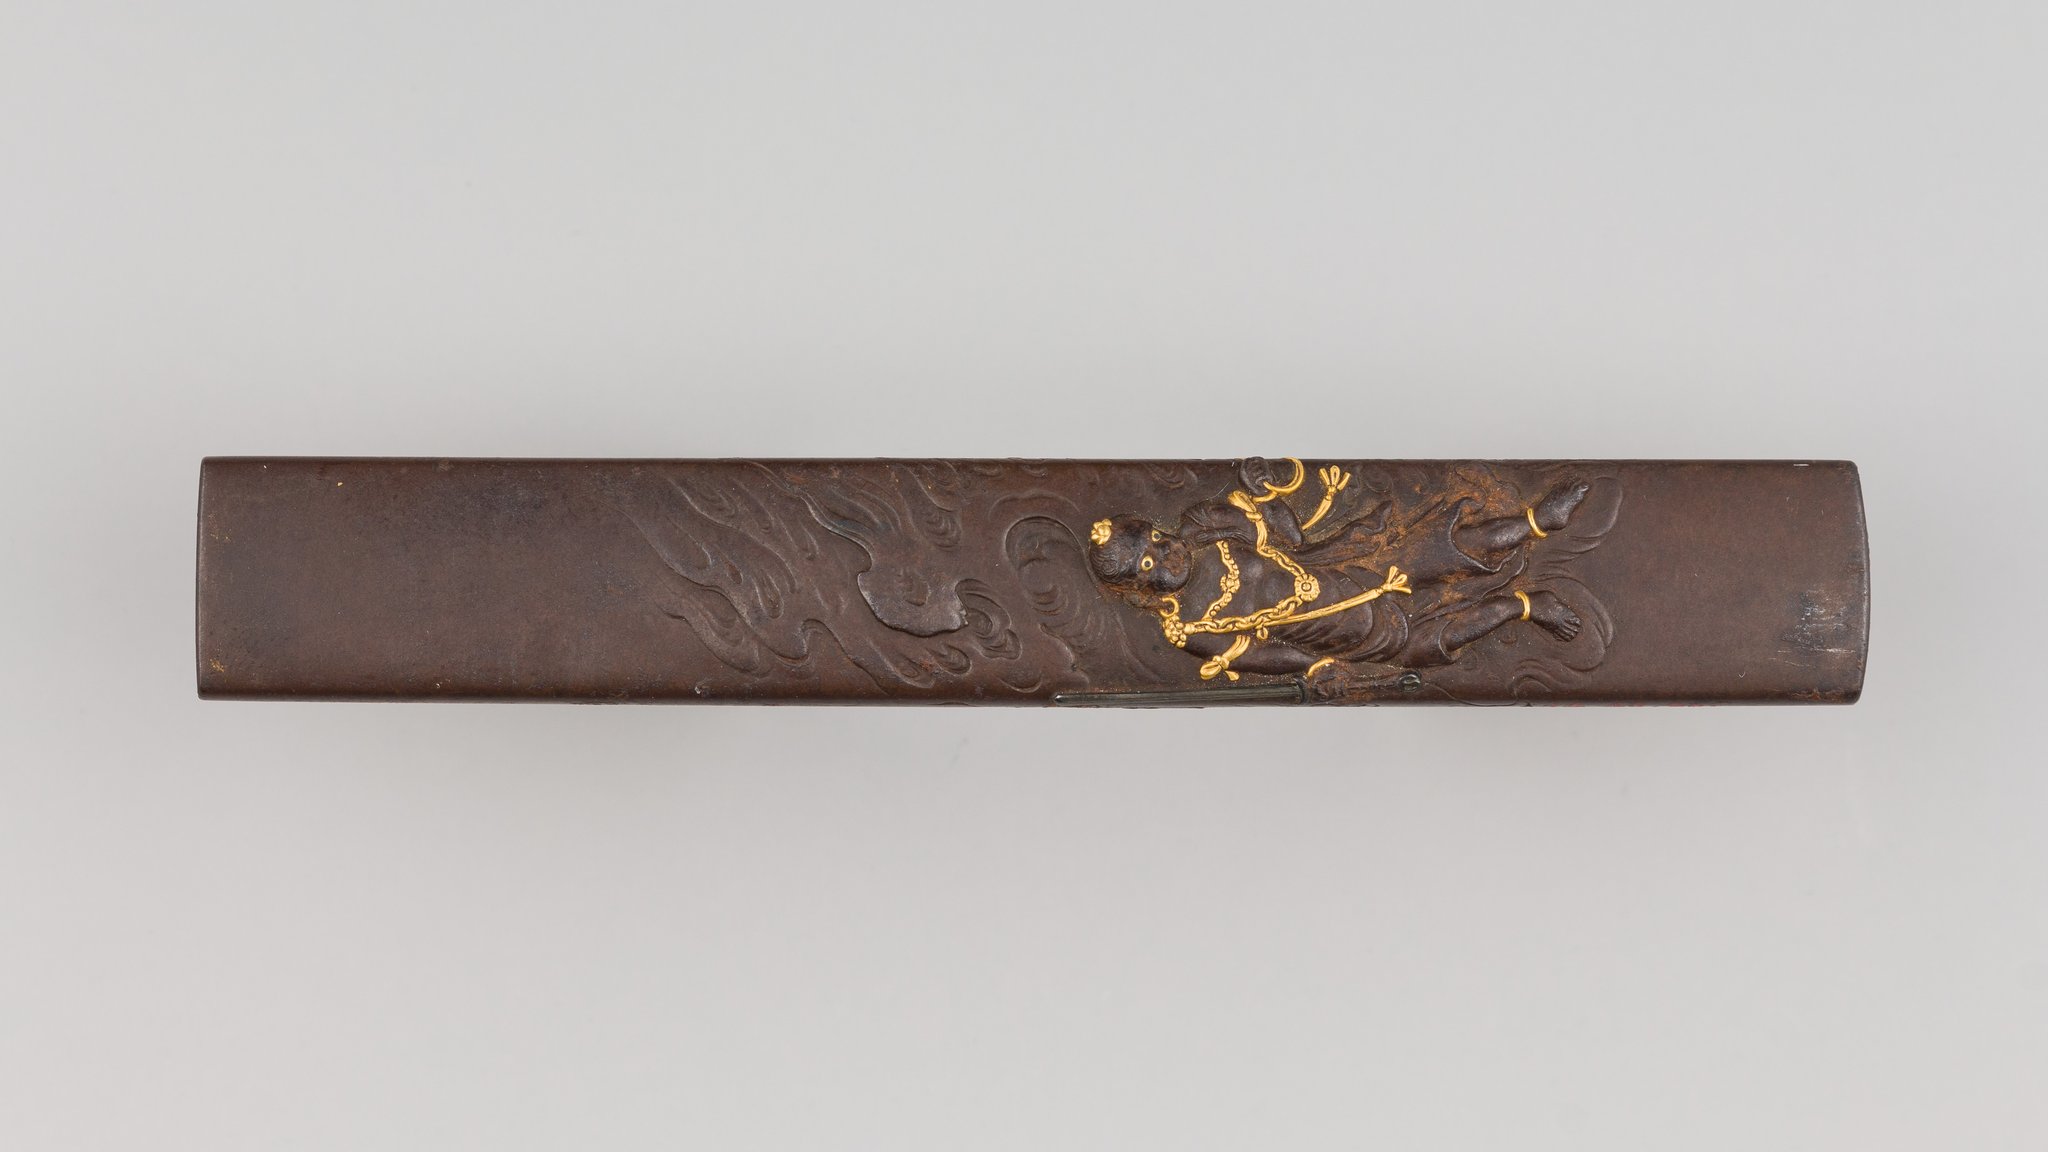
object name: knife handle kozuka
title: Knife Handle (Kozuka)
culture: japanese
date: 1801-1900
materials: gold alloy, gold, iron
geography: japan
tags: men